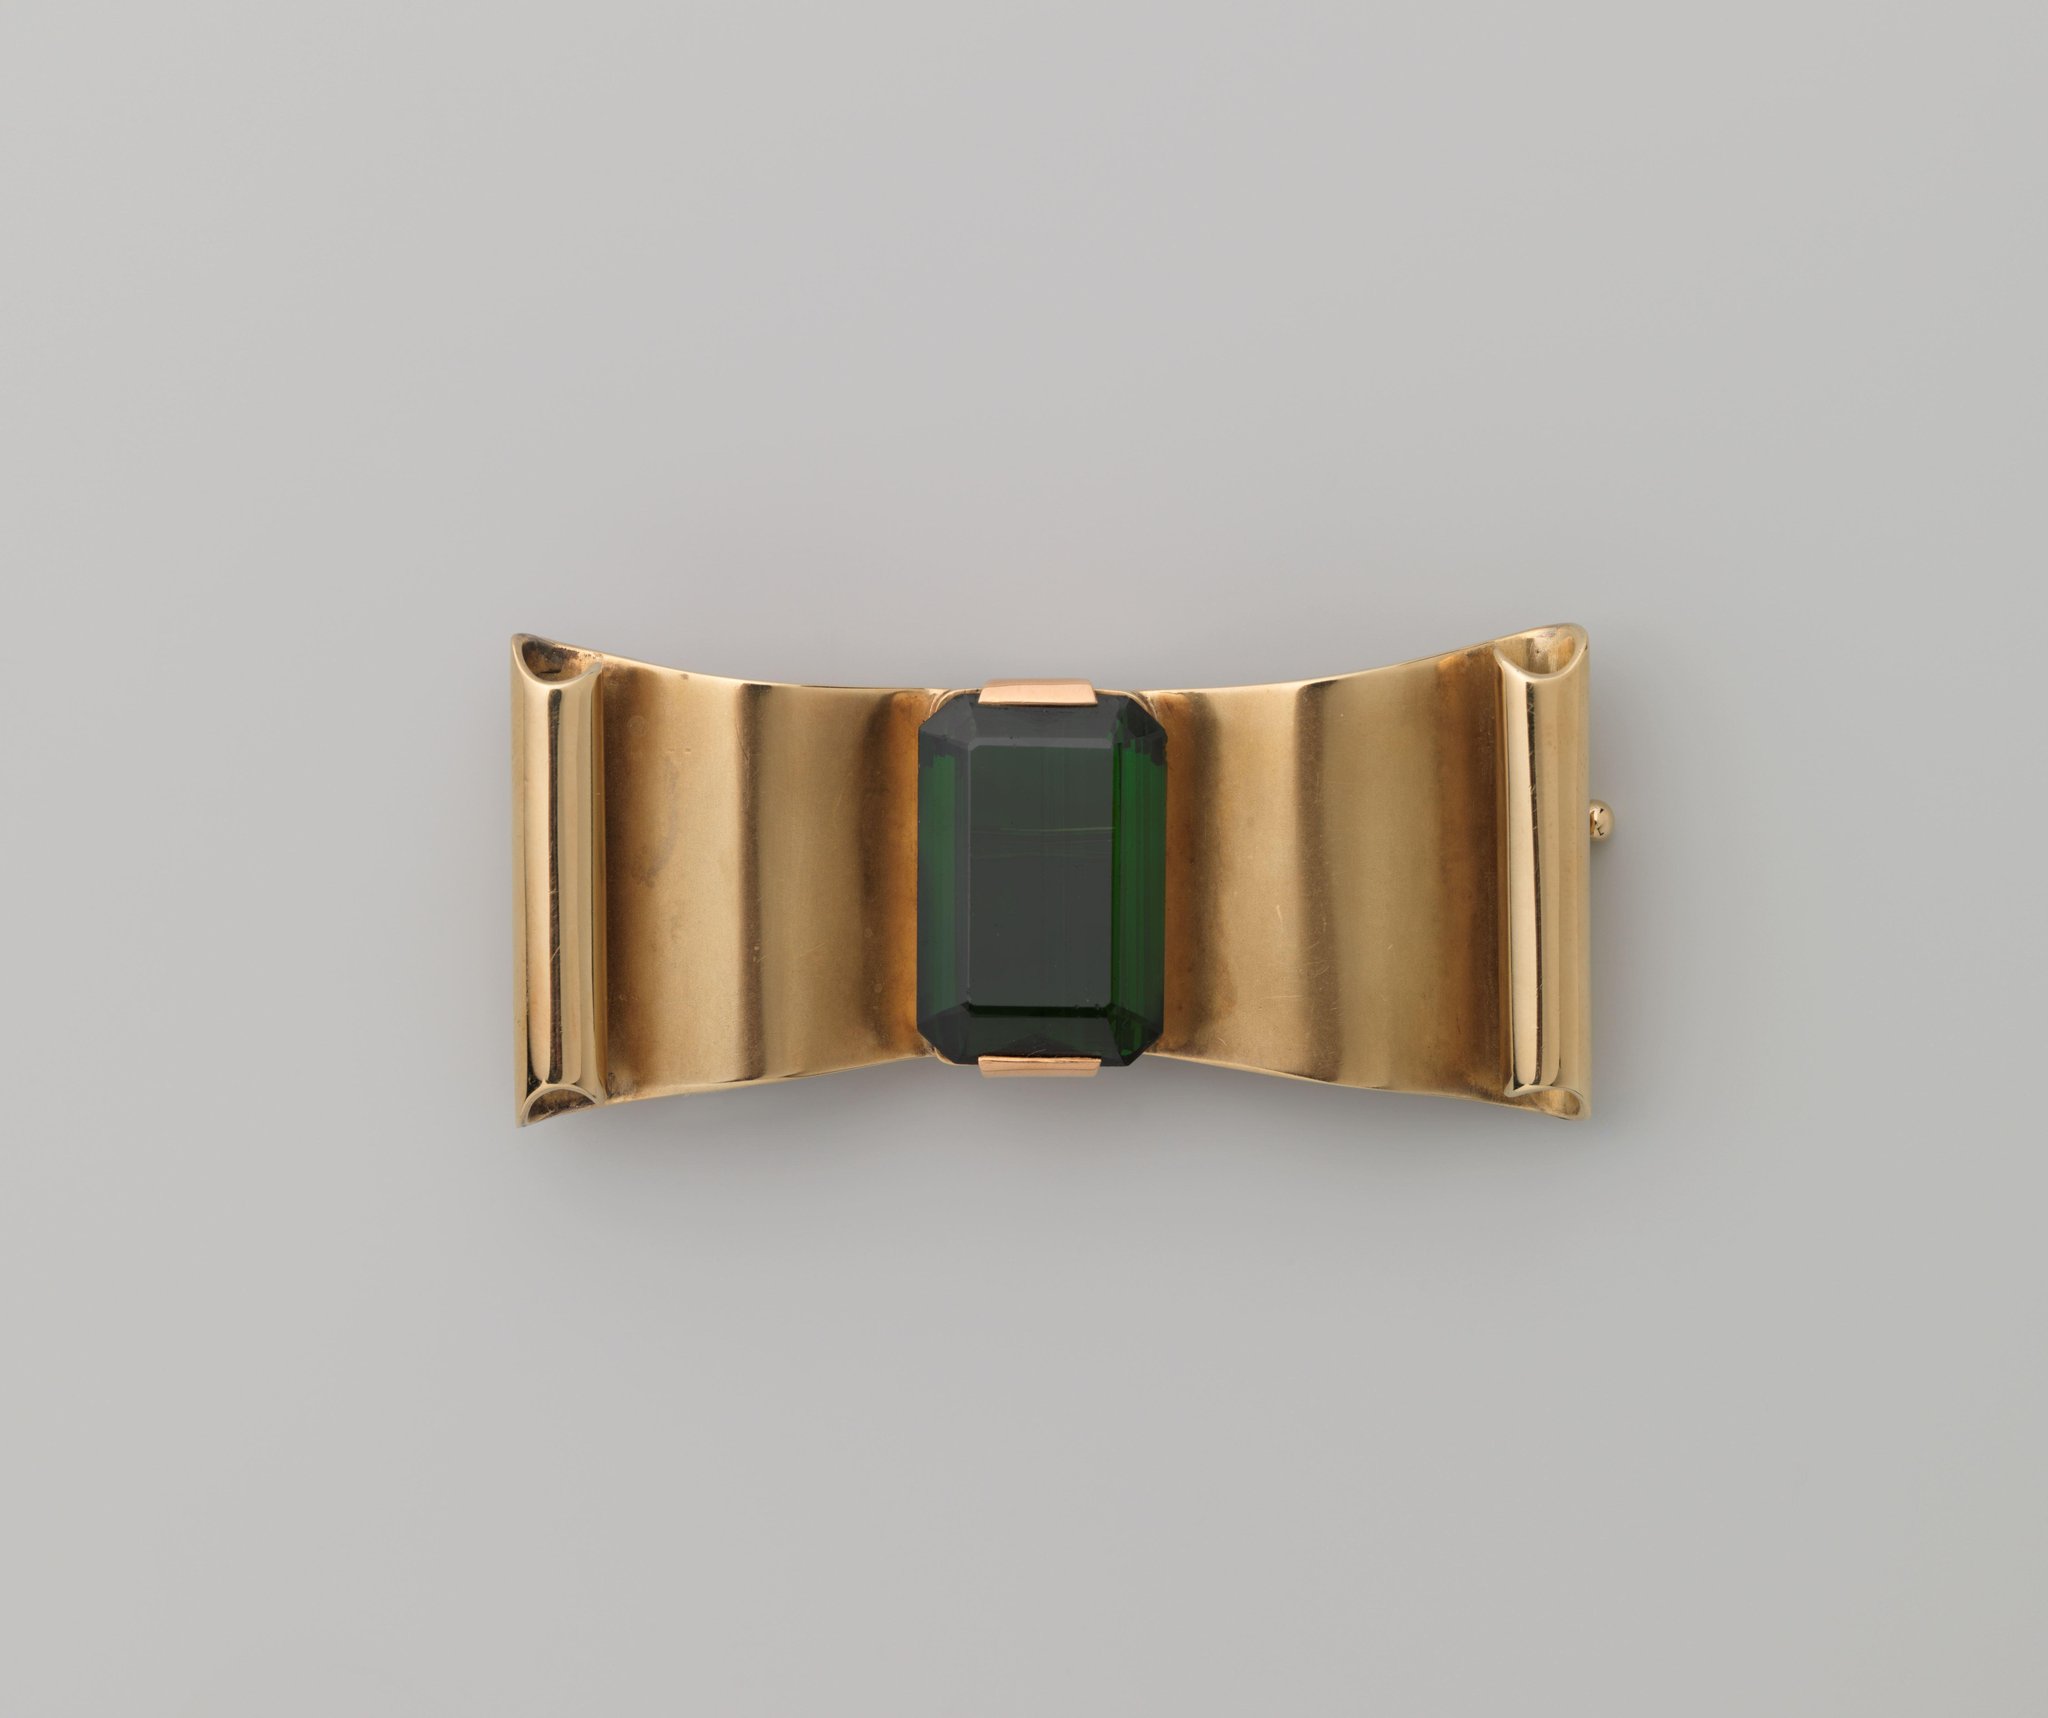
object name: brooch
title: Strikbroche van goud met diepgroene synthetische spinel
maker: Anonymous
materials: gold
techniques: grinding, polish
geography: netherlands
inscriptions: maker's mark: ‘? JH ?’, alloy mark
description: Rechthoekige symmetrische strikbroche van goud met diepgroene synthetische spinel. Aan de bovenzijde van de strik is het goud gematteerd, de randen zijn gepolijst. Aan de achterzijde is de strik voorzien van een kanonsluiting, iets boven het midden, zodat hij goed middenvoor en hoog tegen de halslijn kan worden gedragen. De steen is emeraud geslepen.